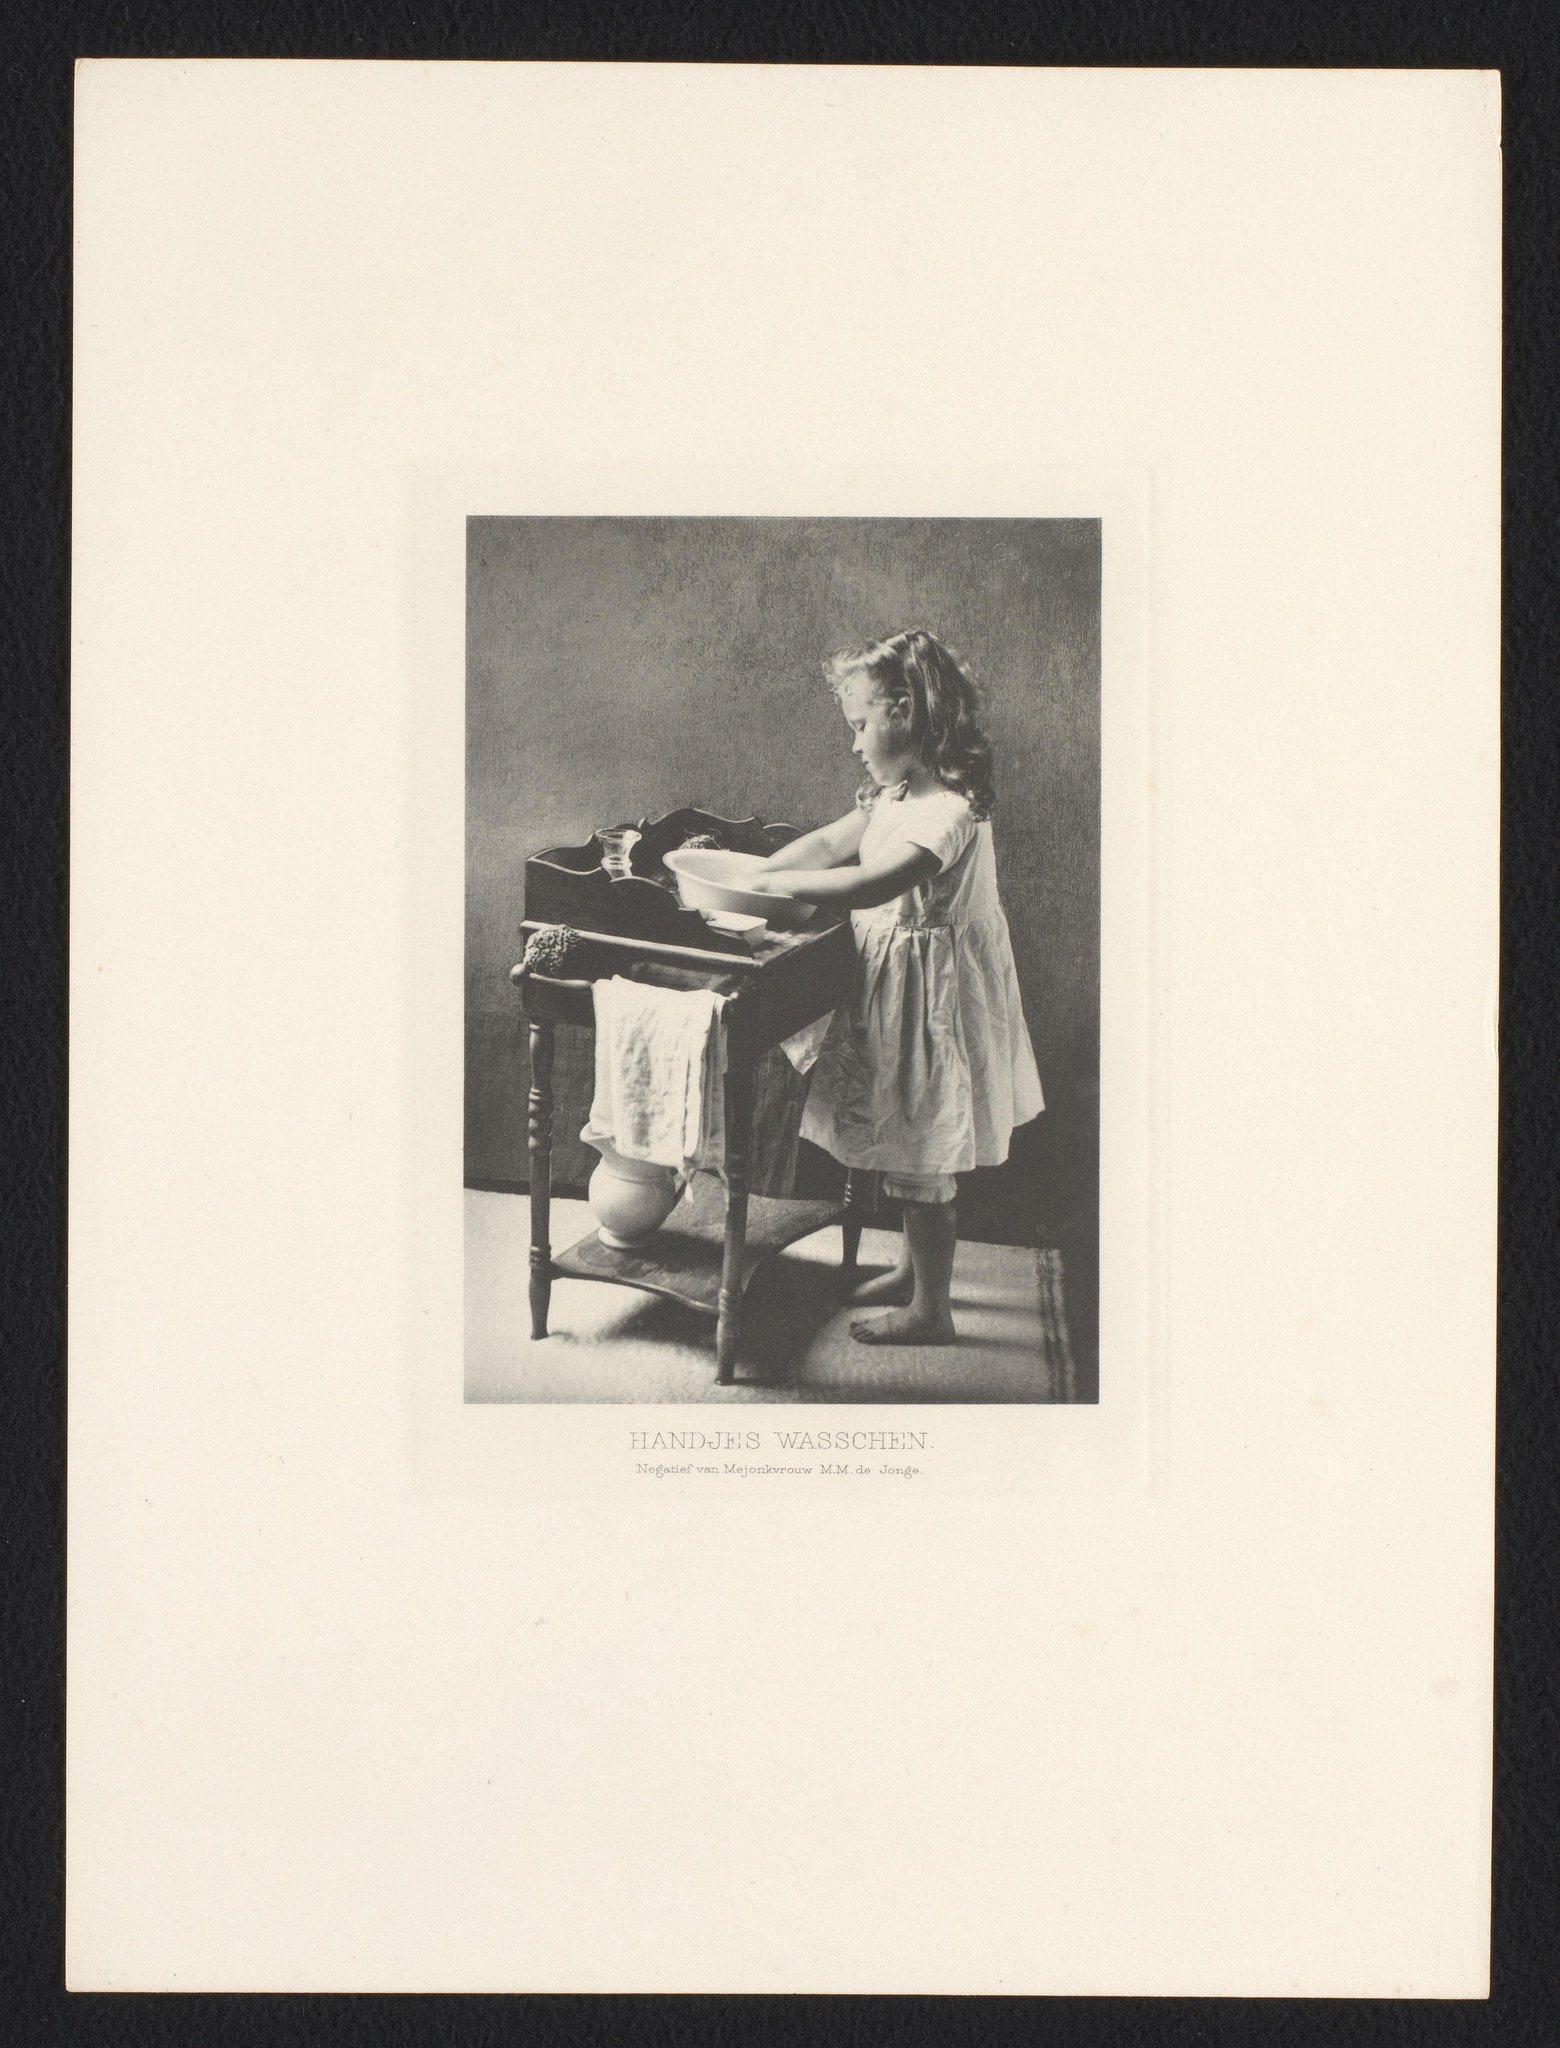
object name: page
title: Handjes wasschen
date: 1899-1904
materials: paper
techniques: photoaquatint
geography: netherlands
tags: child, female infant